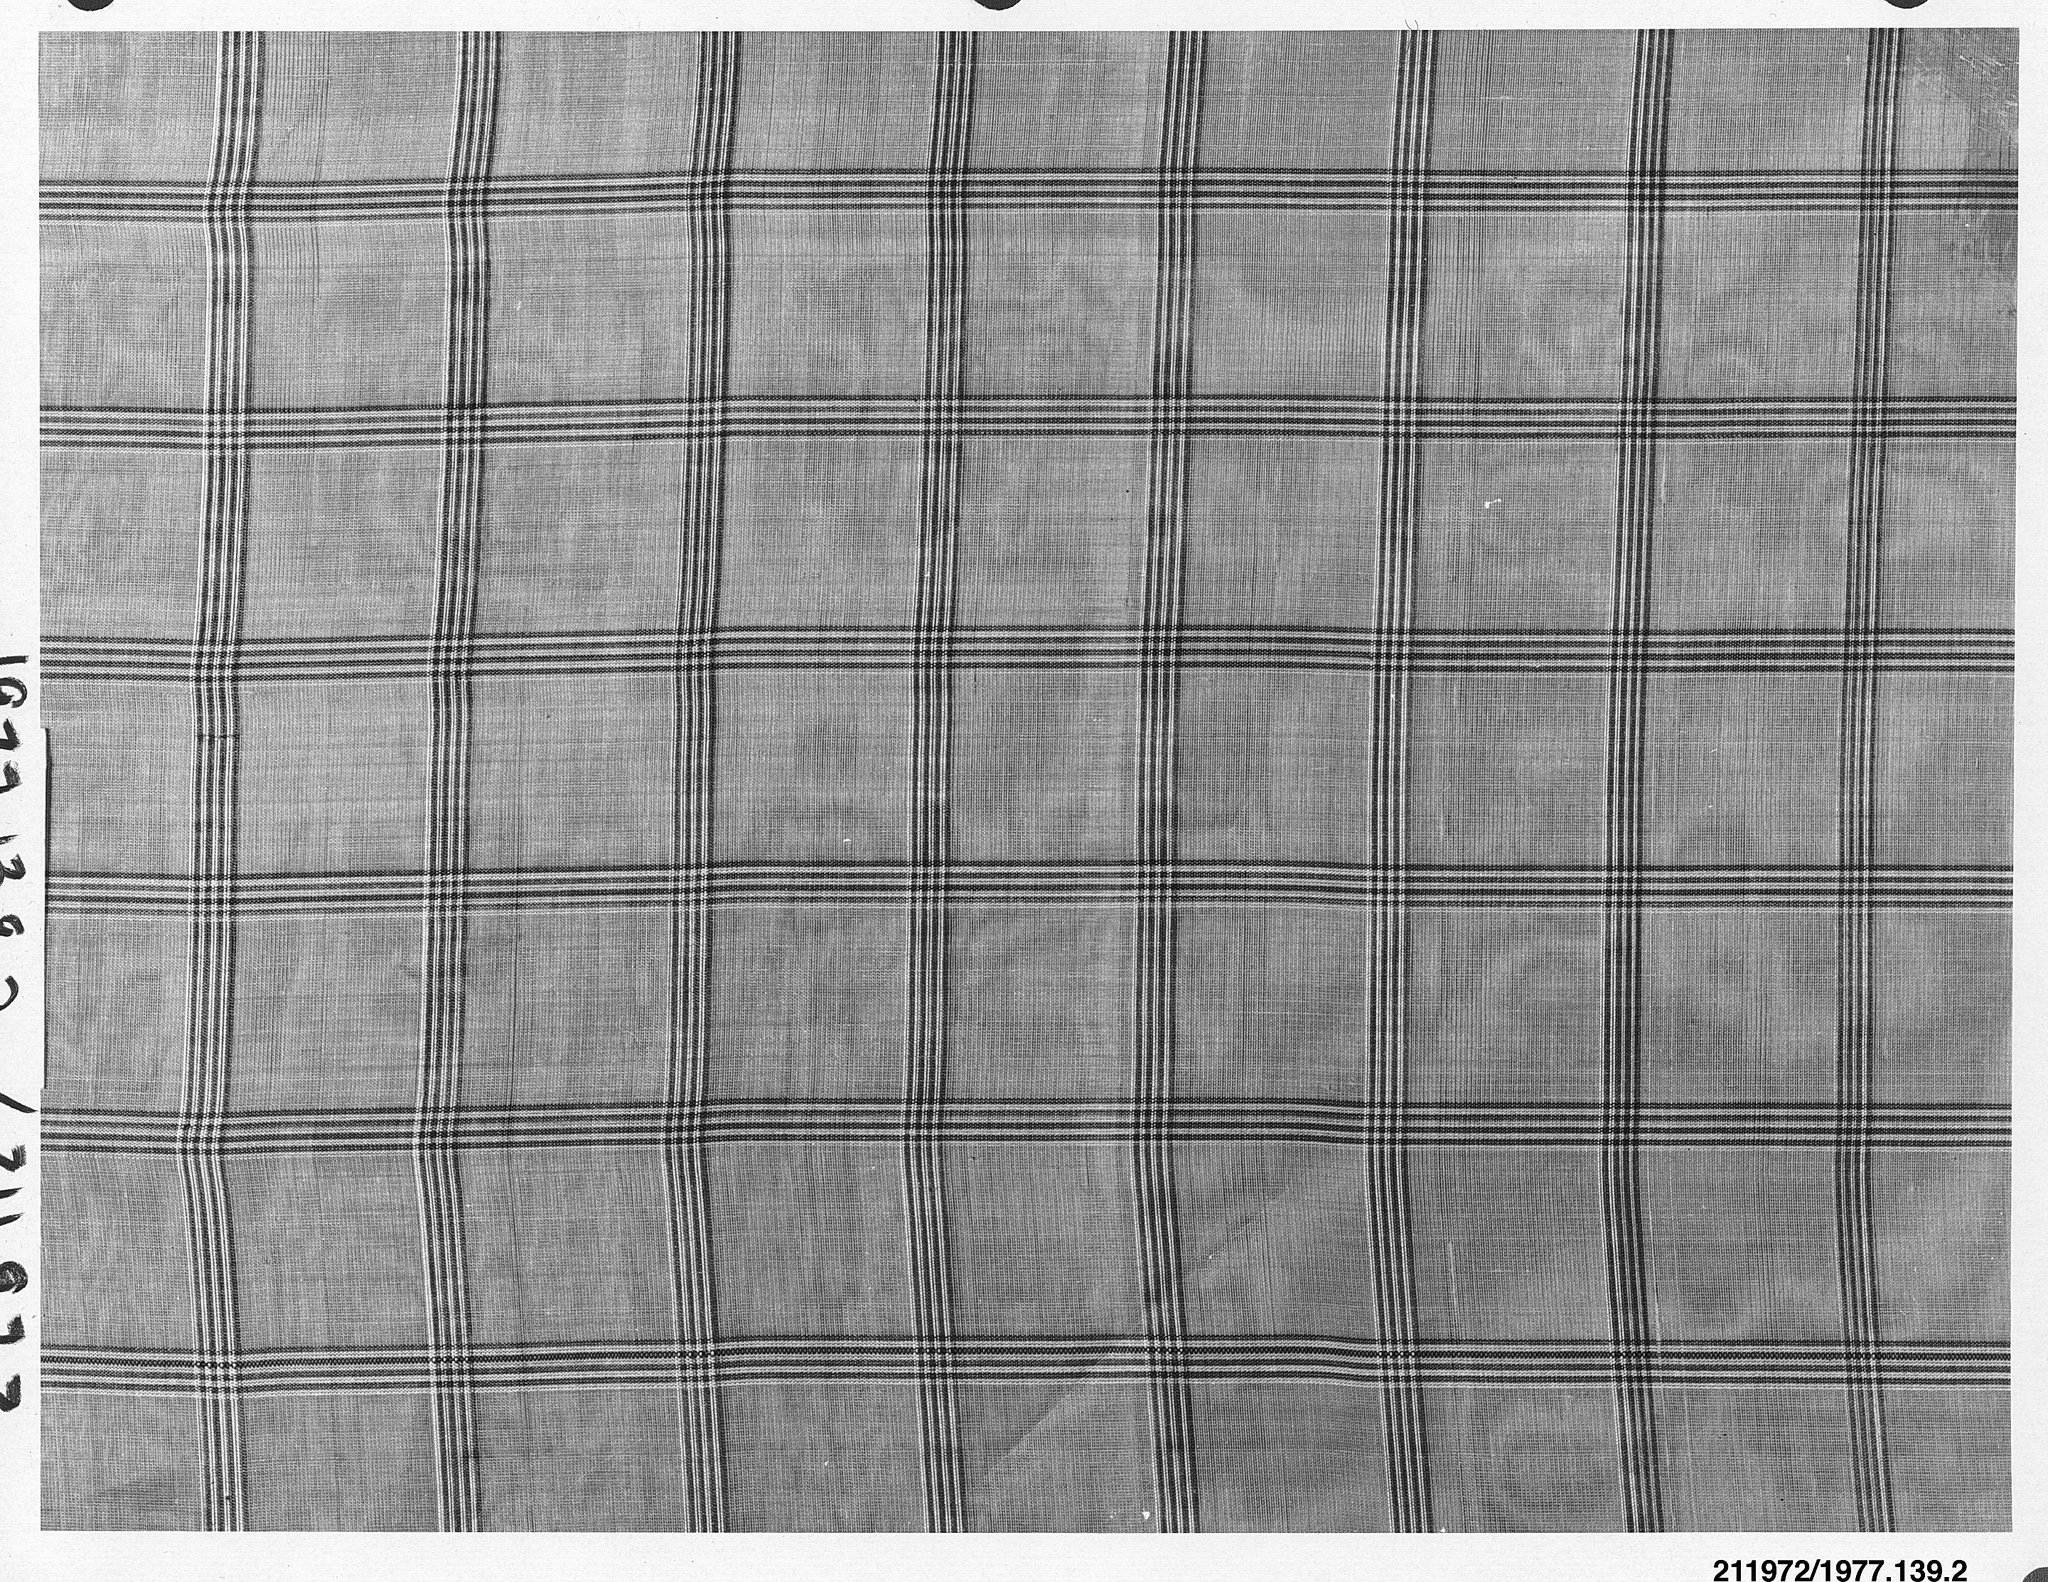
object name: piece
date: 1850